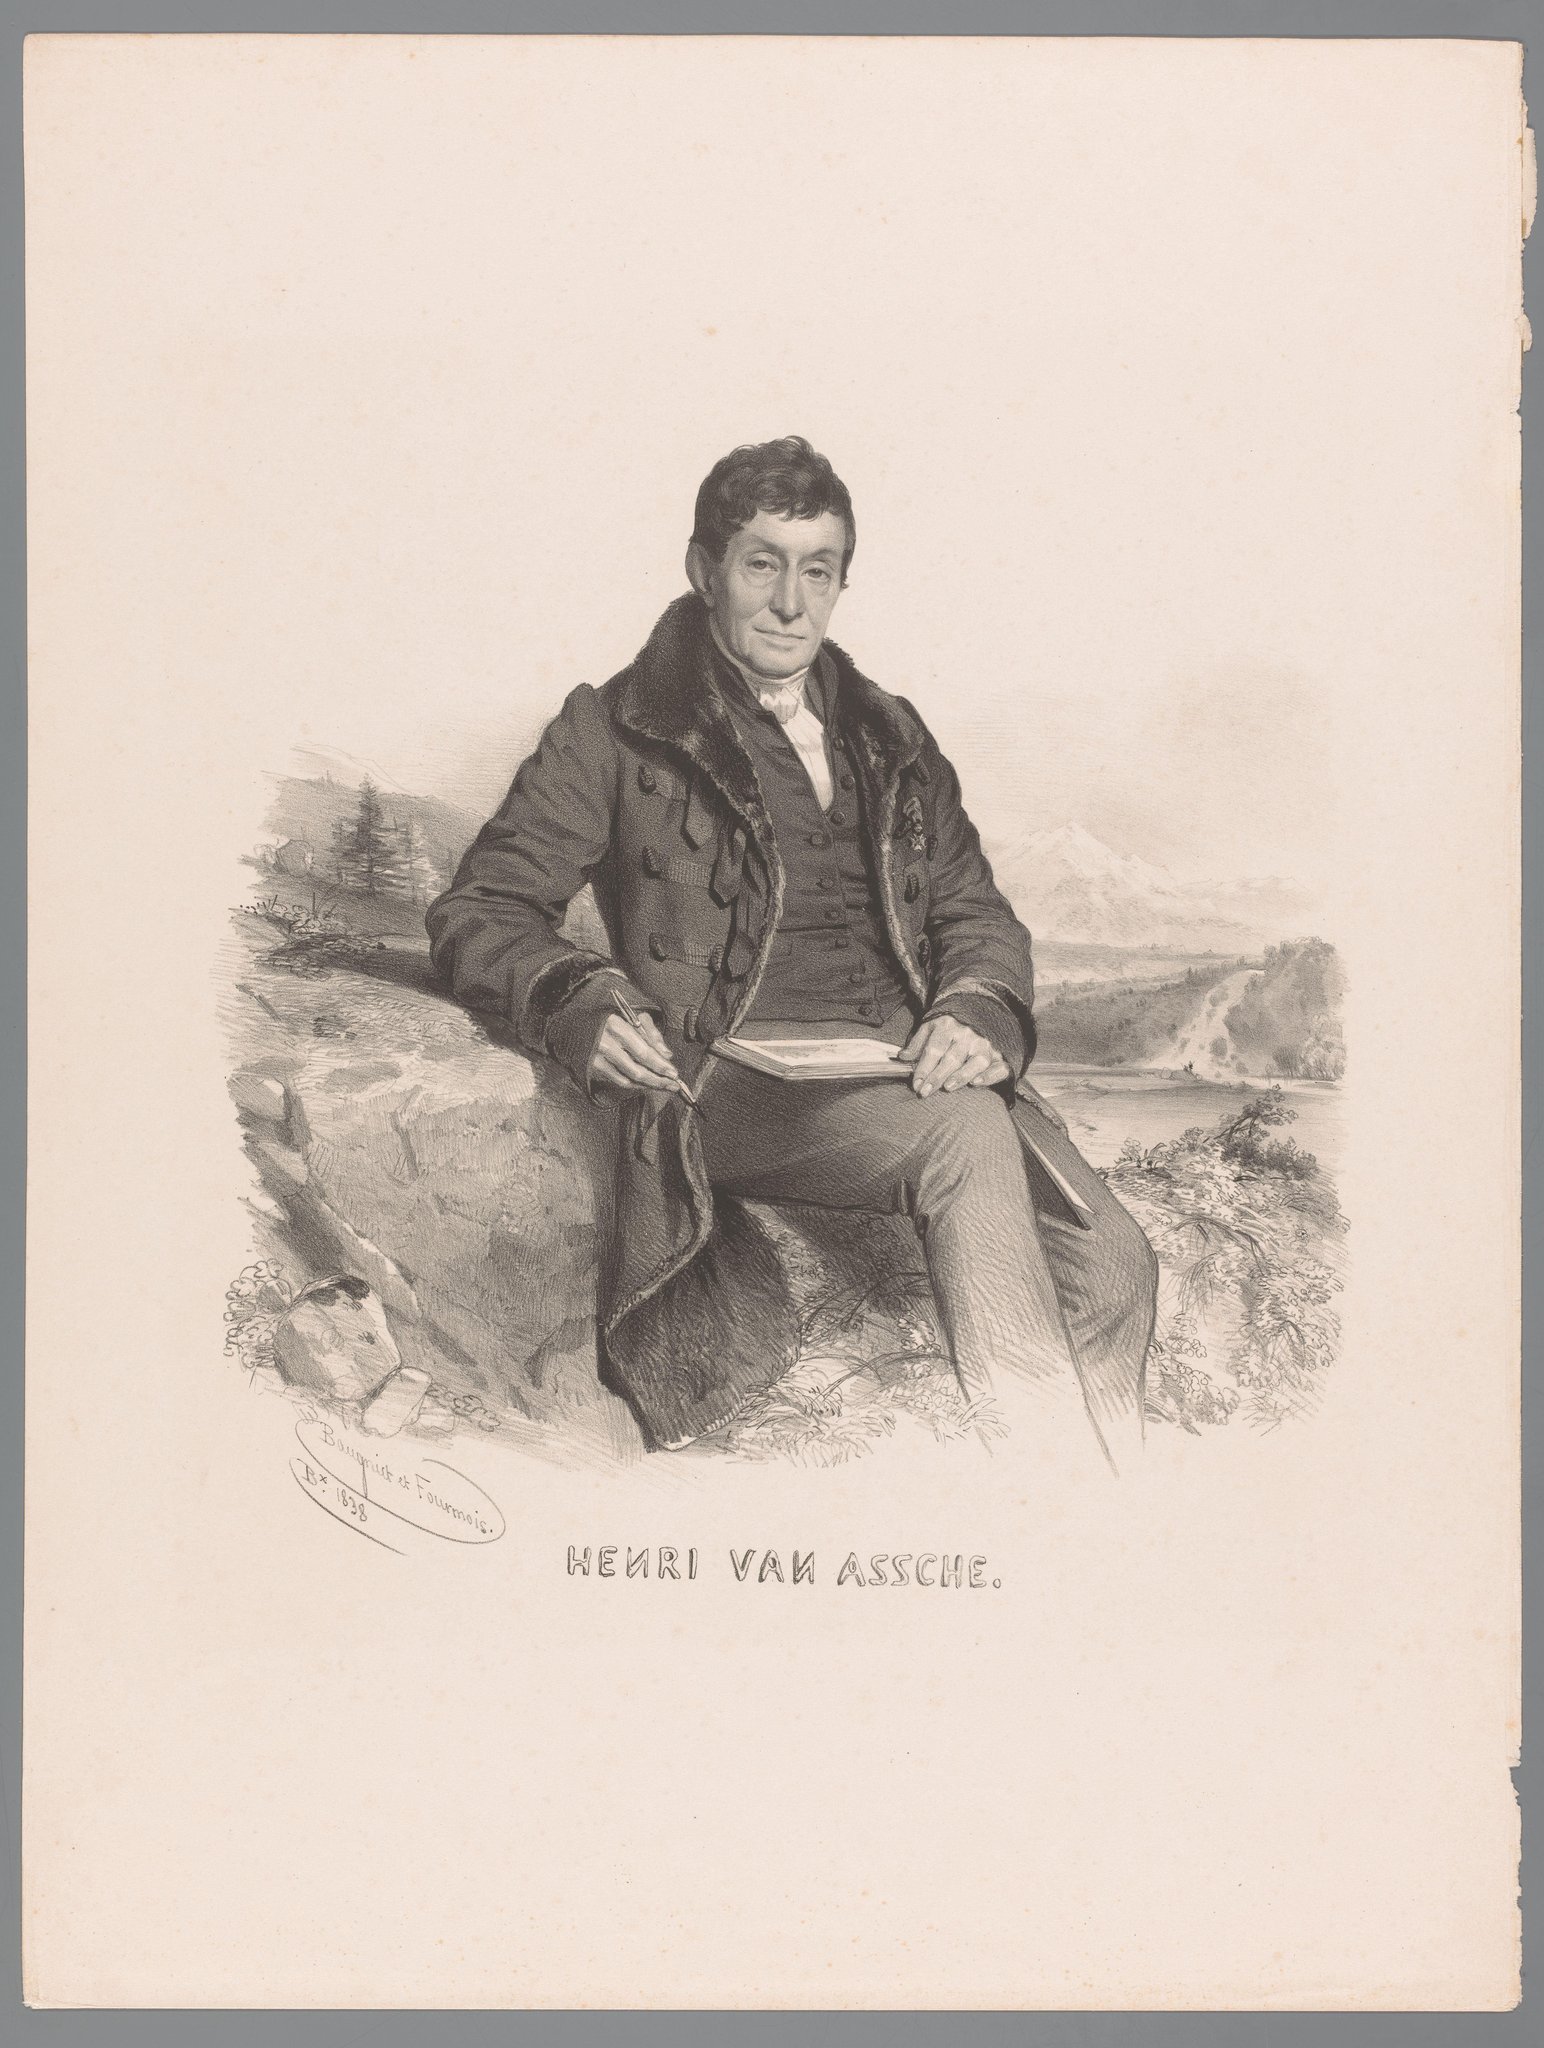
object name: print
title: Portret van Henri van Assche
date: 1838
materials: paper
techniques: lithograph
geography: brussels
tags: brussels, print maker, henri van assche, adult man, historical persons, artist at work, in his workshop - bb - out of doors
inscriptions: date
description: Prent verschenen in: Baugniet, Charles. Les artistes contemporains: portraits lithographiés d'après nature, accompagnés de notices sur la vie et les ouvrages de chacun d'eux. Brussel: De Wasme-Pletinckx, [1836-1840].